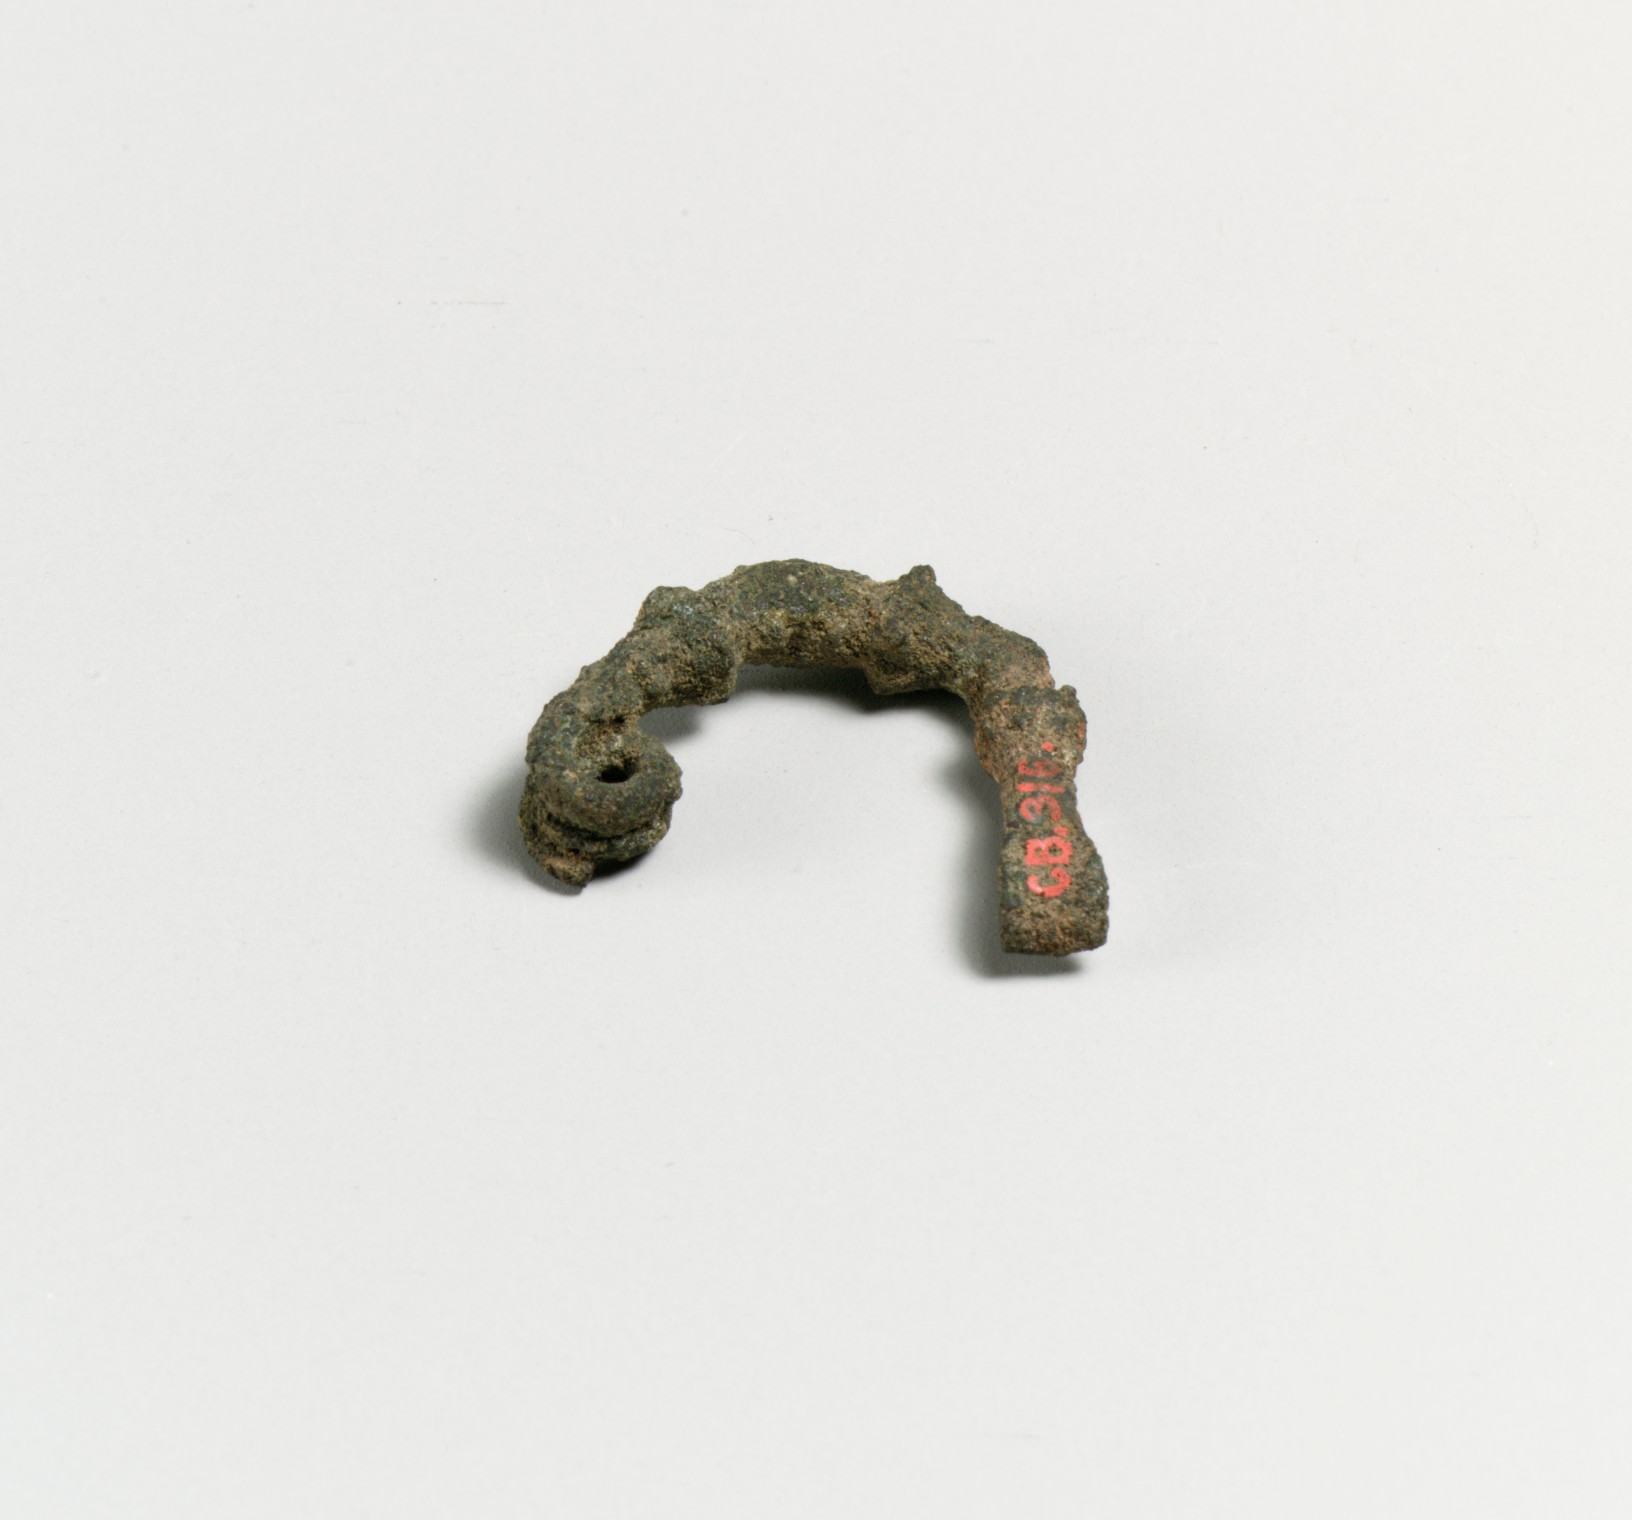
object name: fibula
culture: cypriot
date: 3900 BCE-100 CE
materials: bronze